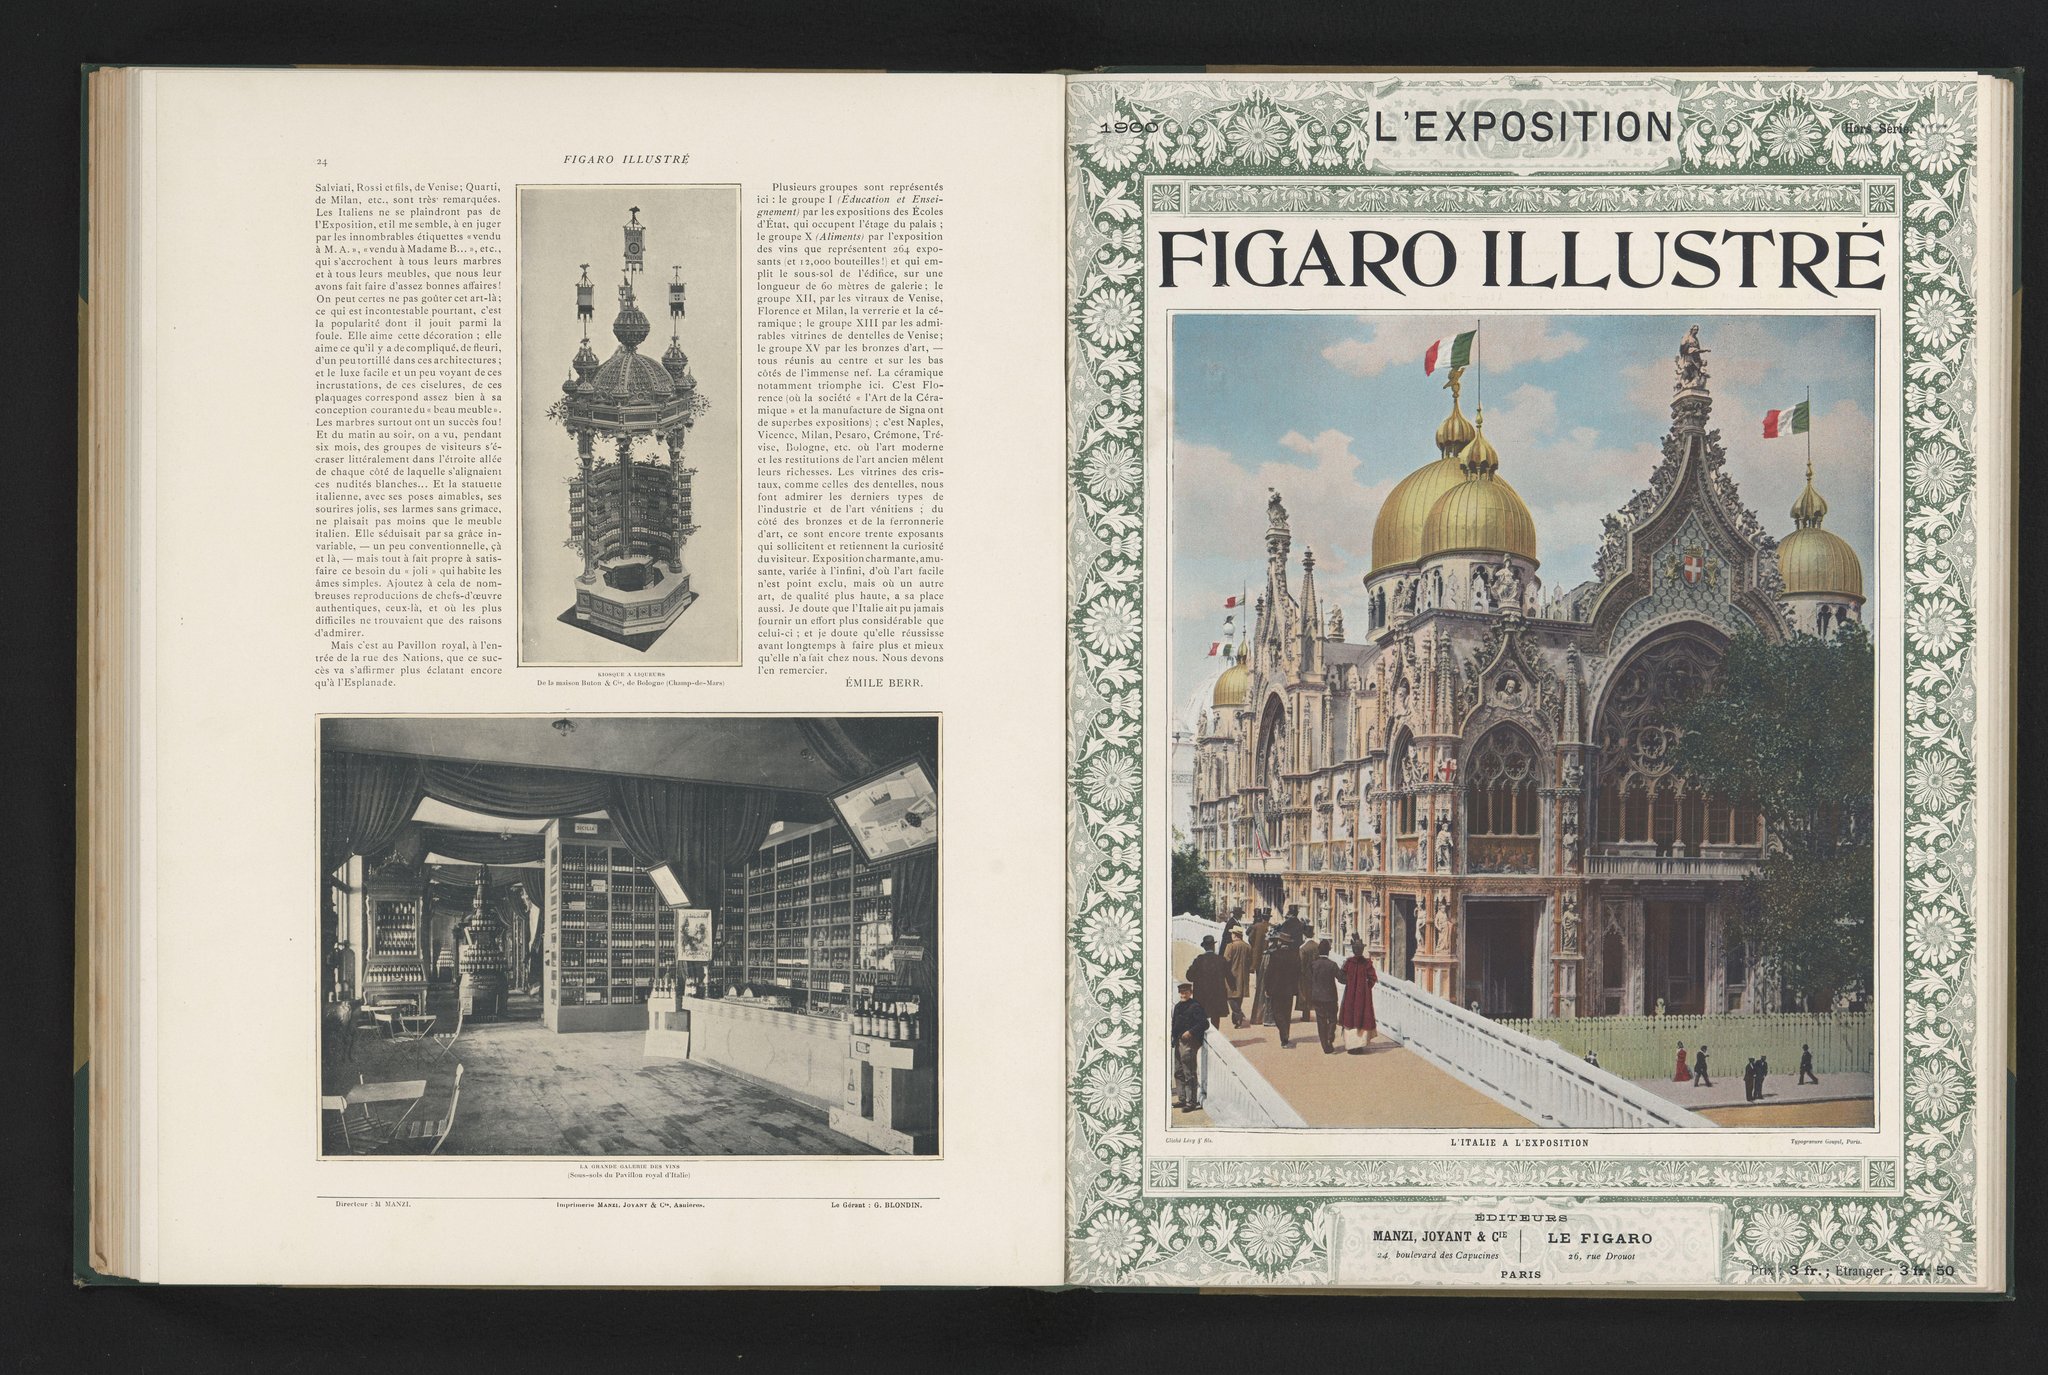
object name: reproduction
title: L'Italie a l'exposition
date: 1885-1901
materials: paper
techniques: four-color autotype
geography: paris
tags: world fair, world exhibition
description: Prent tegenover pagina 24 van Figaro-Illustré (Novembre 1900).